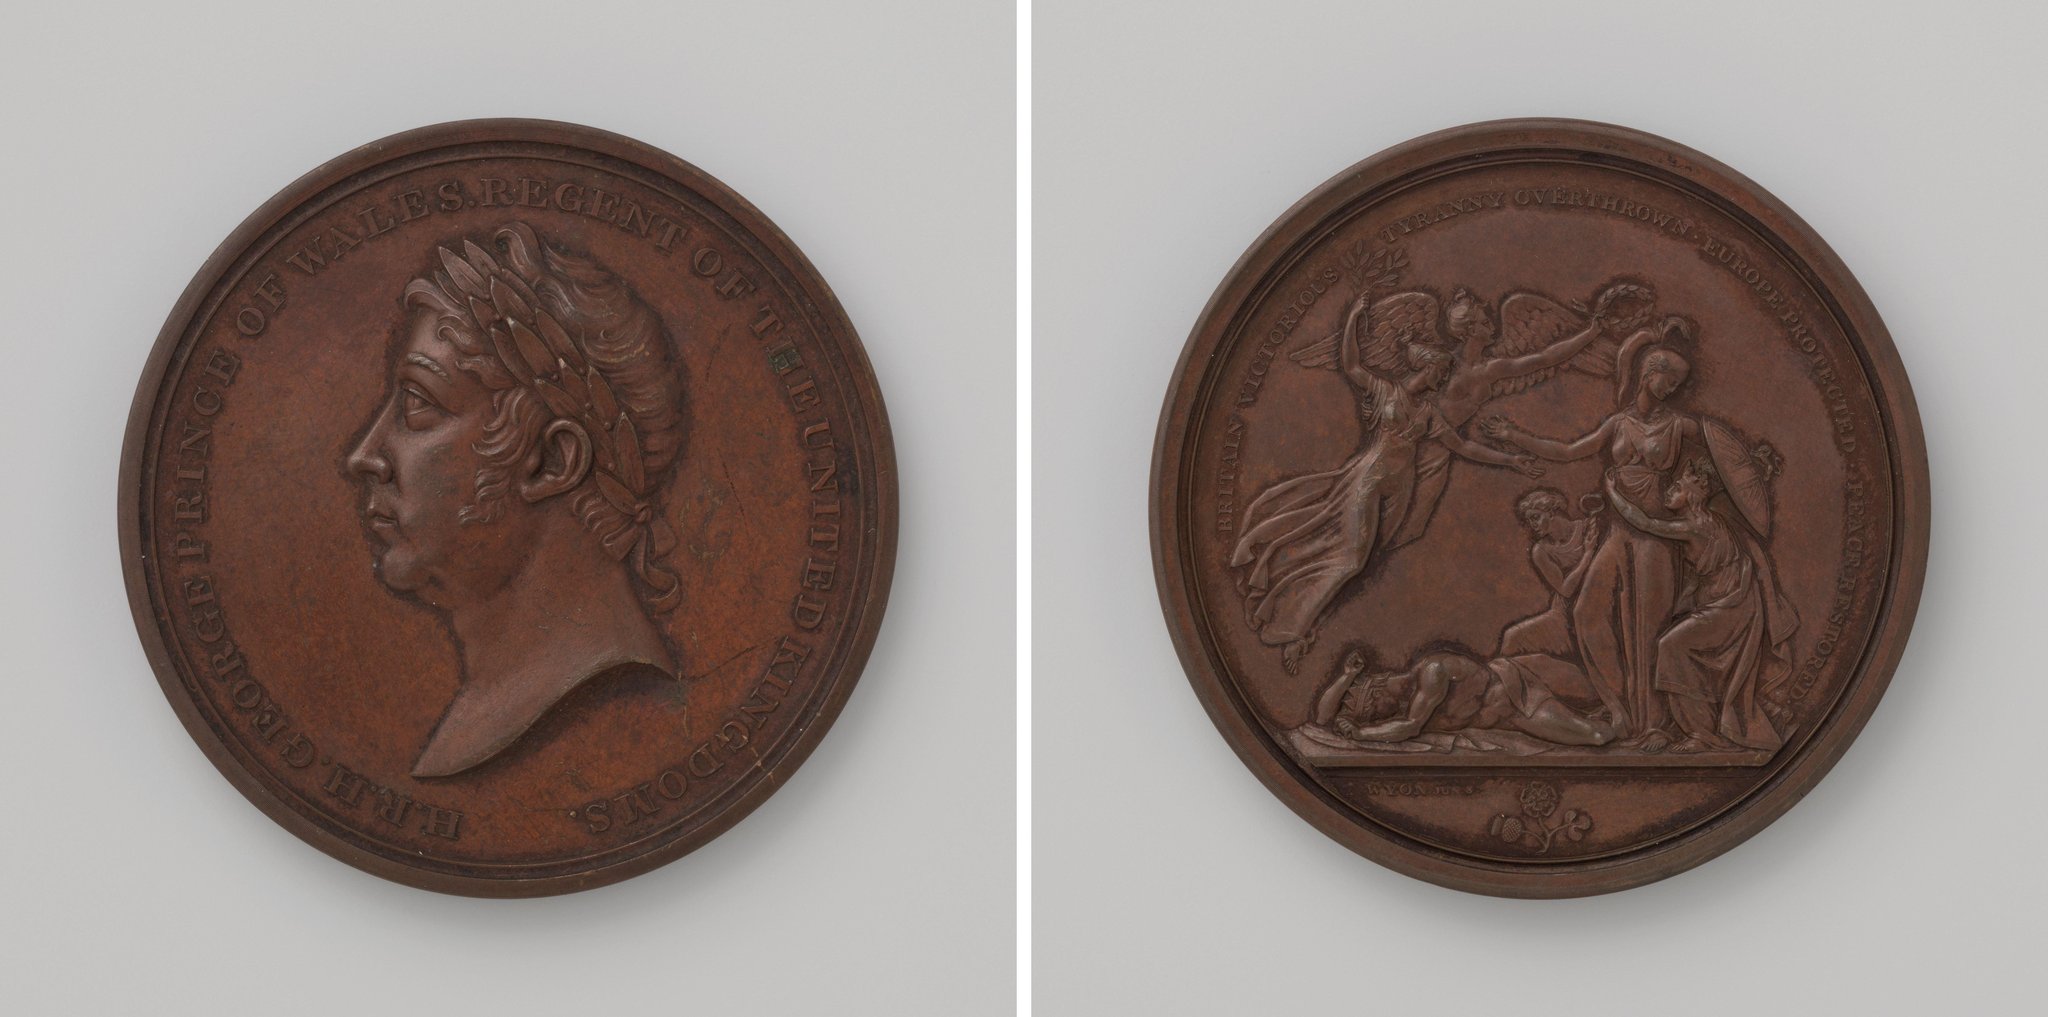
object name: history medal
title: Tweede vrede van Parijs tussen Frankrijk en de geallieerden, ter ere van George, prins-regent van Engeland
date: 1815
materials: bronze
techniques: striking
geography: london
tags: george iv (koning van het verenigd koninkrijk), paris